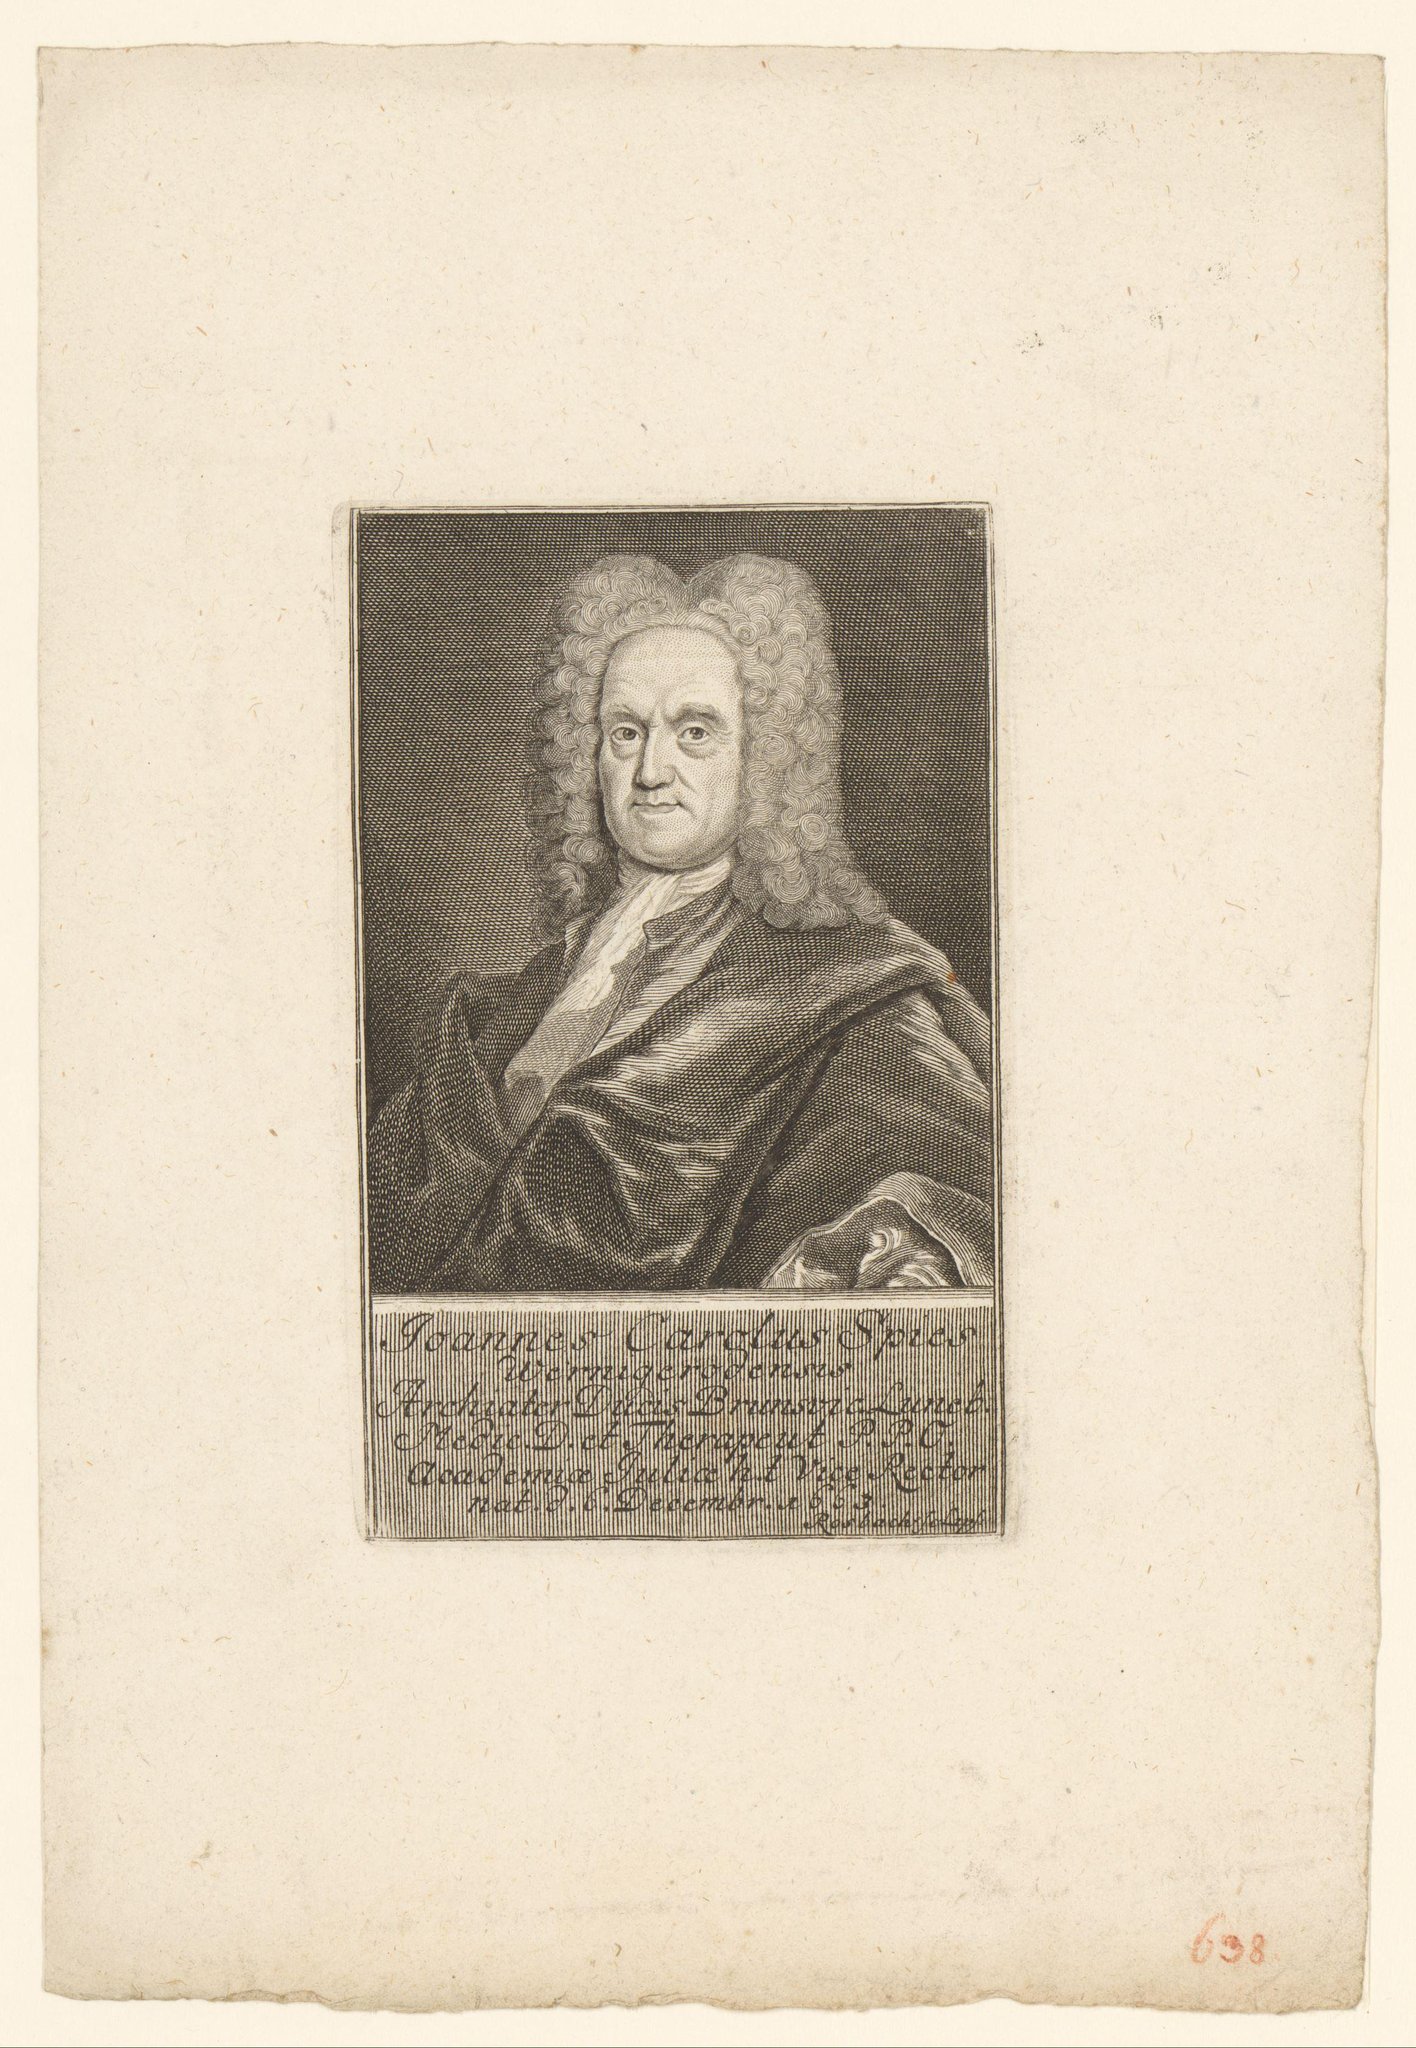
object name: print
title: Portret van Johann Carl Spies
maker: johann friedrich rosbach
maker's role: print maker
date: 1700-1749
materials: paper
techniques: engraving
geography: leipzig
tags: historical persons, wig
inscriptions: collector's mark: Lugt 2228